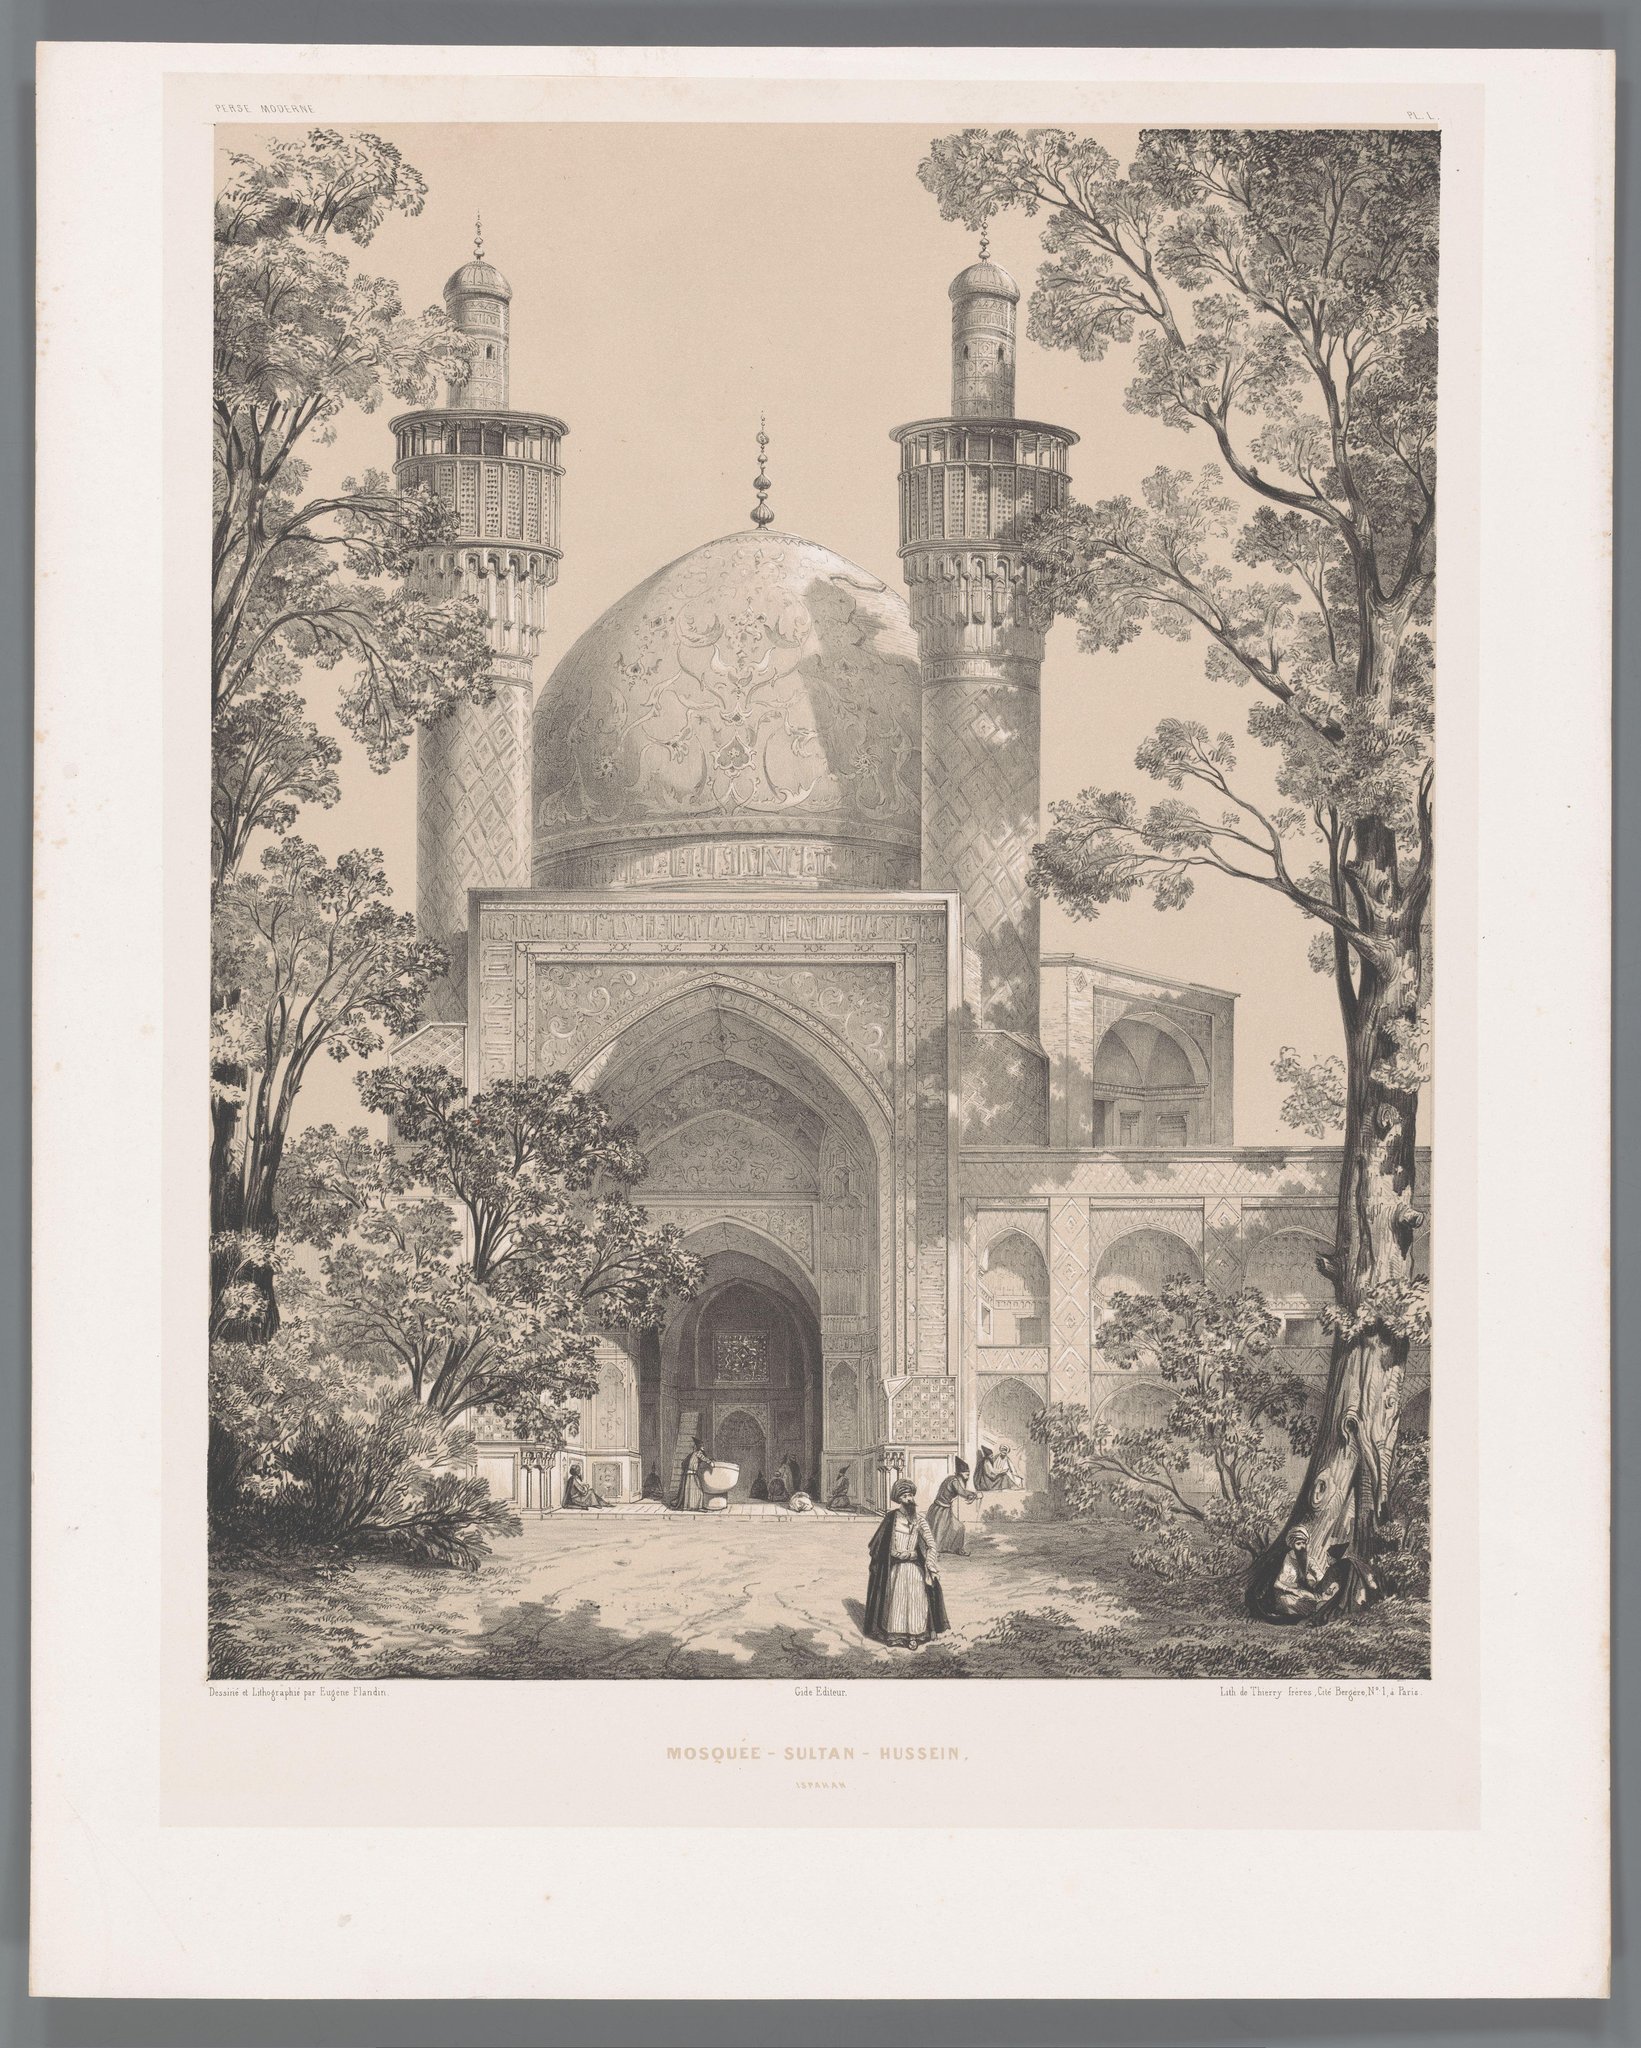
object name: print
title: Mosquée-Sultan-Hussein Ispahan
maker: eugène flandin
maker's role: painter, print maker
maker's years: 1809-1889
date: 1843-1854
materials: paper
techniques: tone lithography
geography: paris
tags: university building, college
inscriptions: collector's mark: Lugt 2228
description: Dit gebouwencomplex staat ook bekend als College van de moeder van Shah Sultan Hussein, of Shah school. Uit: Coste, Pascal-Xavier en Eugène Napoléon Flandin. Voyage en Perse de mm. Eugène Flandin, peintre, et Pascal Coste, architecte (...). 8 dln. Parijs: Gide et Jules Baudry, 1843-1854.